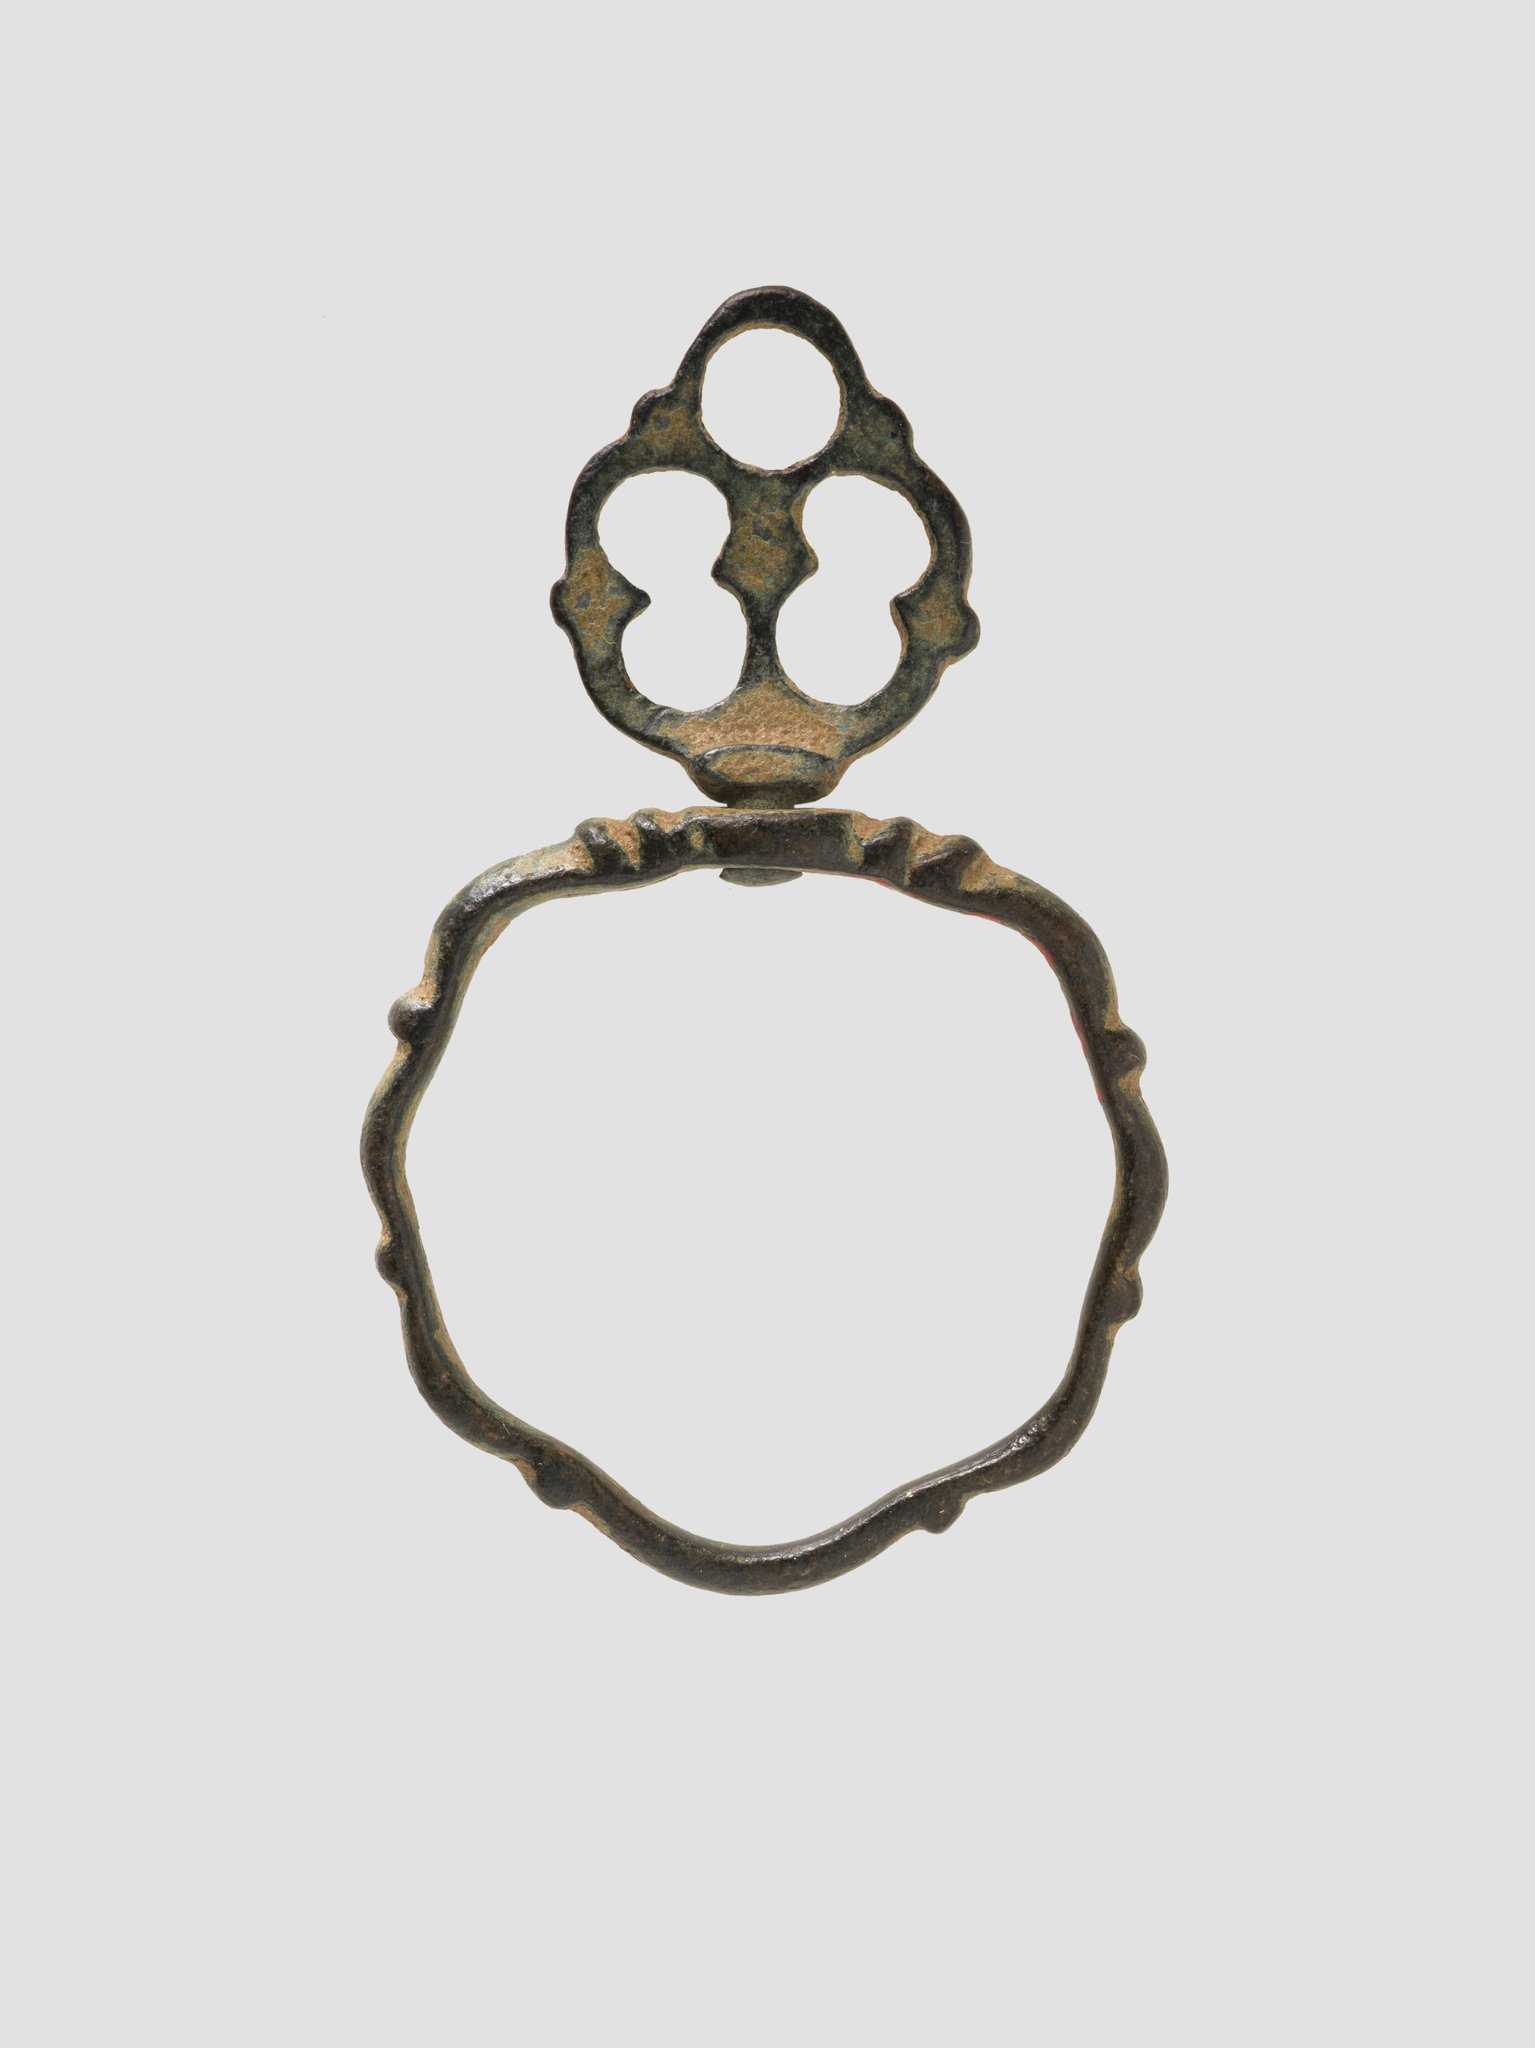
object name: ring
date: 1-1000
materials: bronze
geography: anatolia (?)